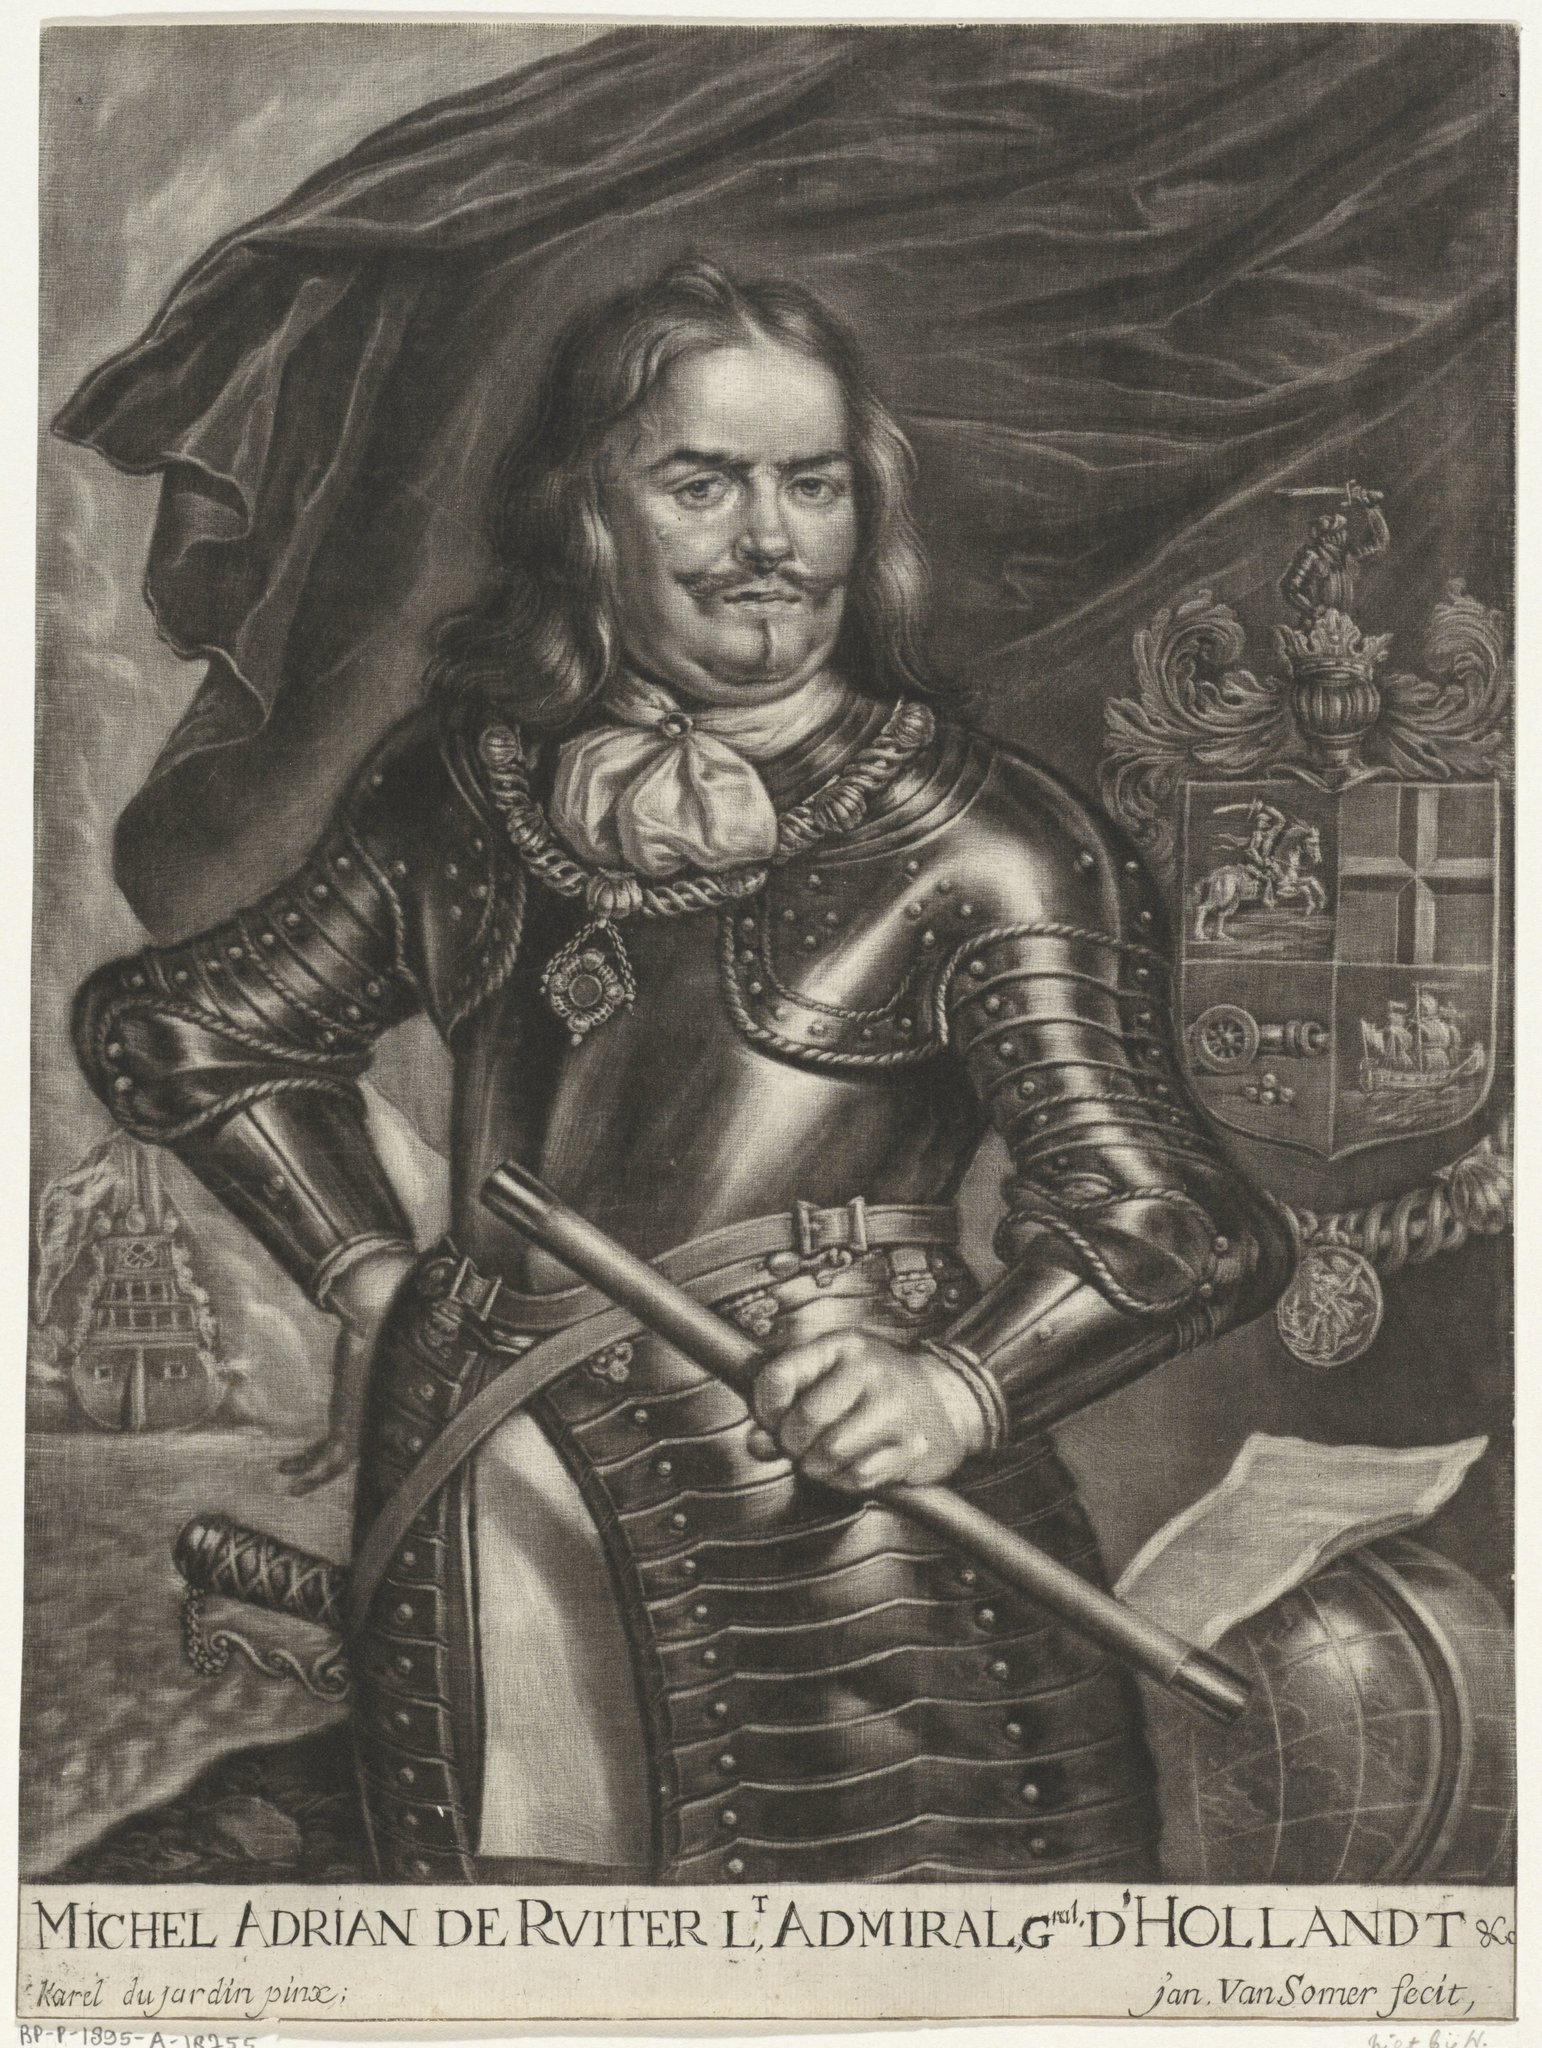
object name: print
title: Portret van admiraal Michiel Adriaenszoon de Ruyter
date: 1655-1700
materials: paper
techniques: mezzotint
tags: flushing, michiel adriaenszoon de ruyter, sailing-ship, sailing-boat, historical persons, armorial bearing, heraldry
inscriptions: collector's mark: Lugt 2228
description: Admiraal Michiel Adriaenszoon de Ruyter in een harnas met om zijn hals een keten waaraan een medaillon. Hij heeft de commandostaf in zijn hand. Op de achtergrond een schip, een vlag en zijn familiewapen. In de marge zijn naam en titels.